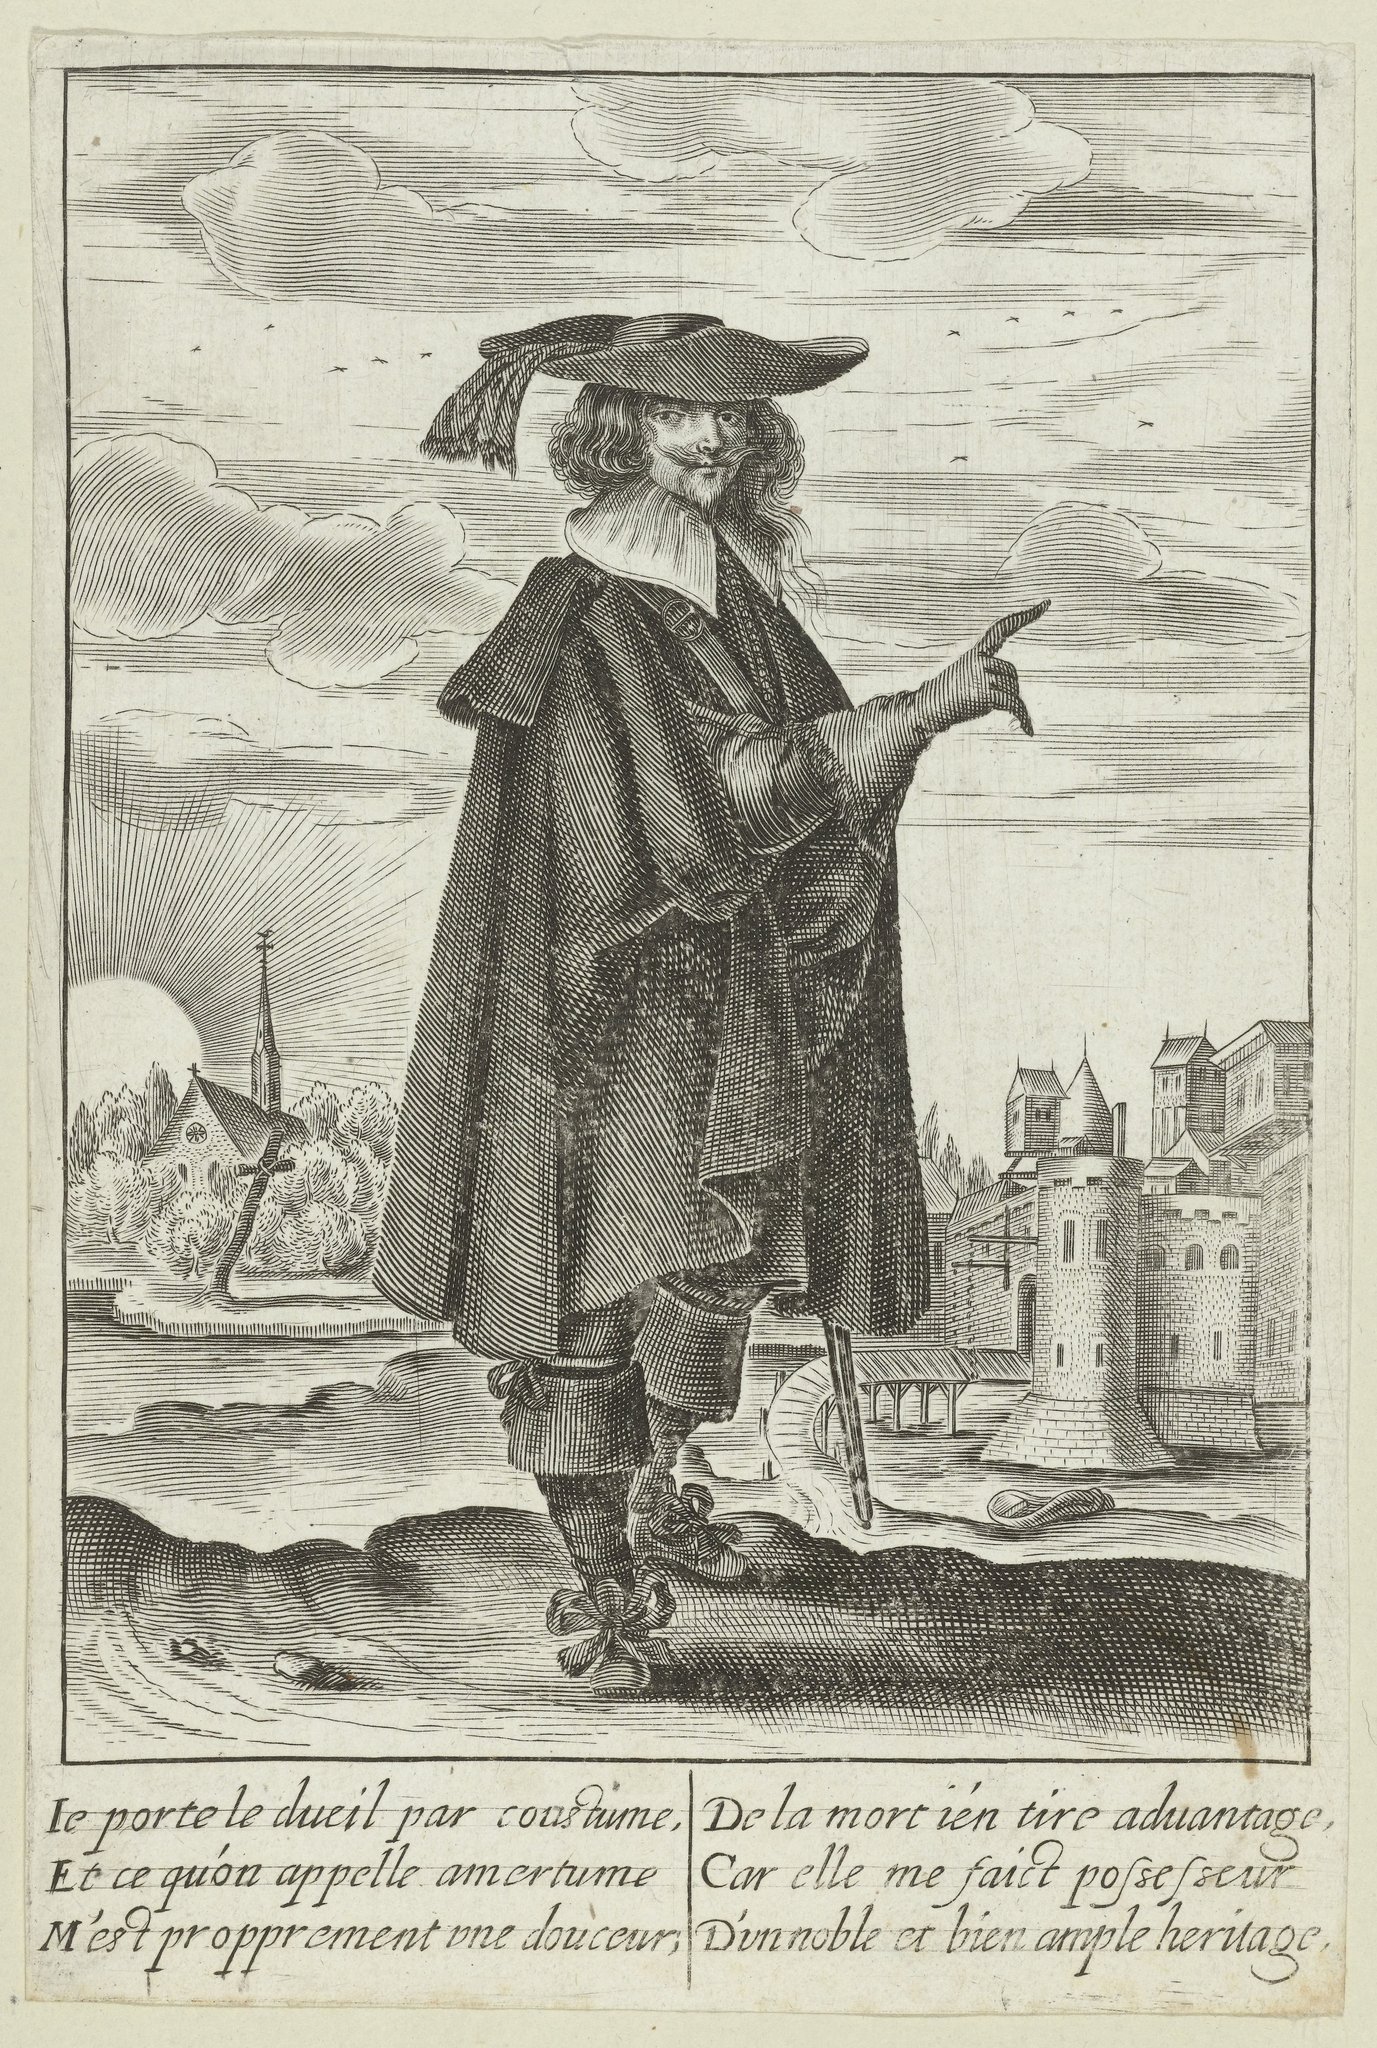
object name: costume print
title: Diversitez d'Habillemens a la mode (...)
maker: isaac briot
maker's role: print maker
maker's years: 1585-1670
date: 1630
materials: paper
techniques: engraving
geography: france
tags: coat (+ men's clothes), head-gear: hat (+ men's clothes), shoes, sandals (+ men's clothes), mourning dress, boots (+ men's clothes)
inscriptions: caption: ‘Je porte le deuil par coustume / Et ce qu'on appelle amertune / M'est propprement une douceur / De la mort i'en tire advantage / Car elle me faict possesseur / D'un noble et bien ample heritage.’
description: Maakt deel uit van een serie van minstens twaalf prenten van kostuums, getiteld: "Diversitez d'Habillemens a la mode; Naifuement portraits sur la differente condition de la Noblesse des Magistrats, et du tiers estat, le tout dédié a Messire Nicolas le Iay Chevalier Seigneur de Tilly, de Maison rouge de St Fargeau et de Villiers Con en sa cour de Parlement". De serie werd uitgegeven door Iacqueq Honeruogt in Parijs, ca. 1630.